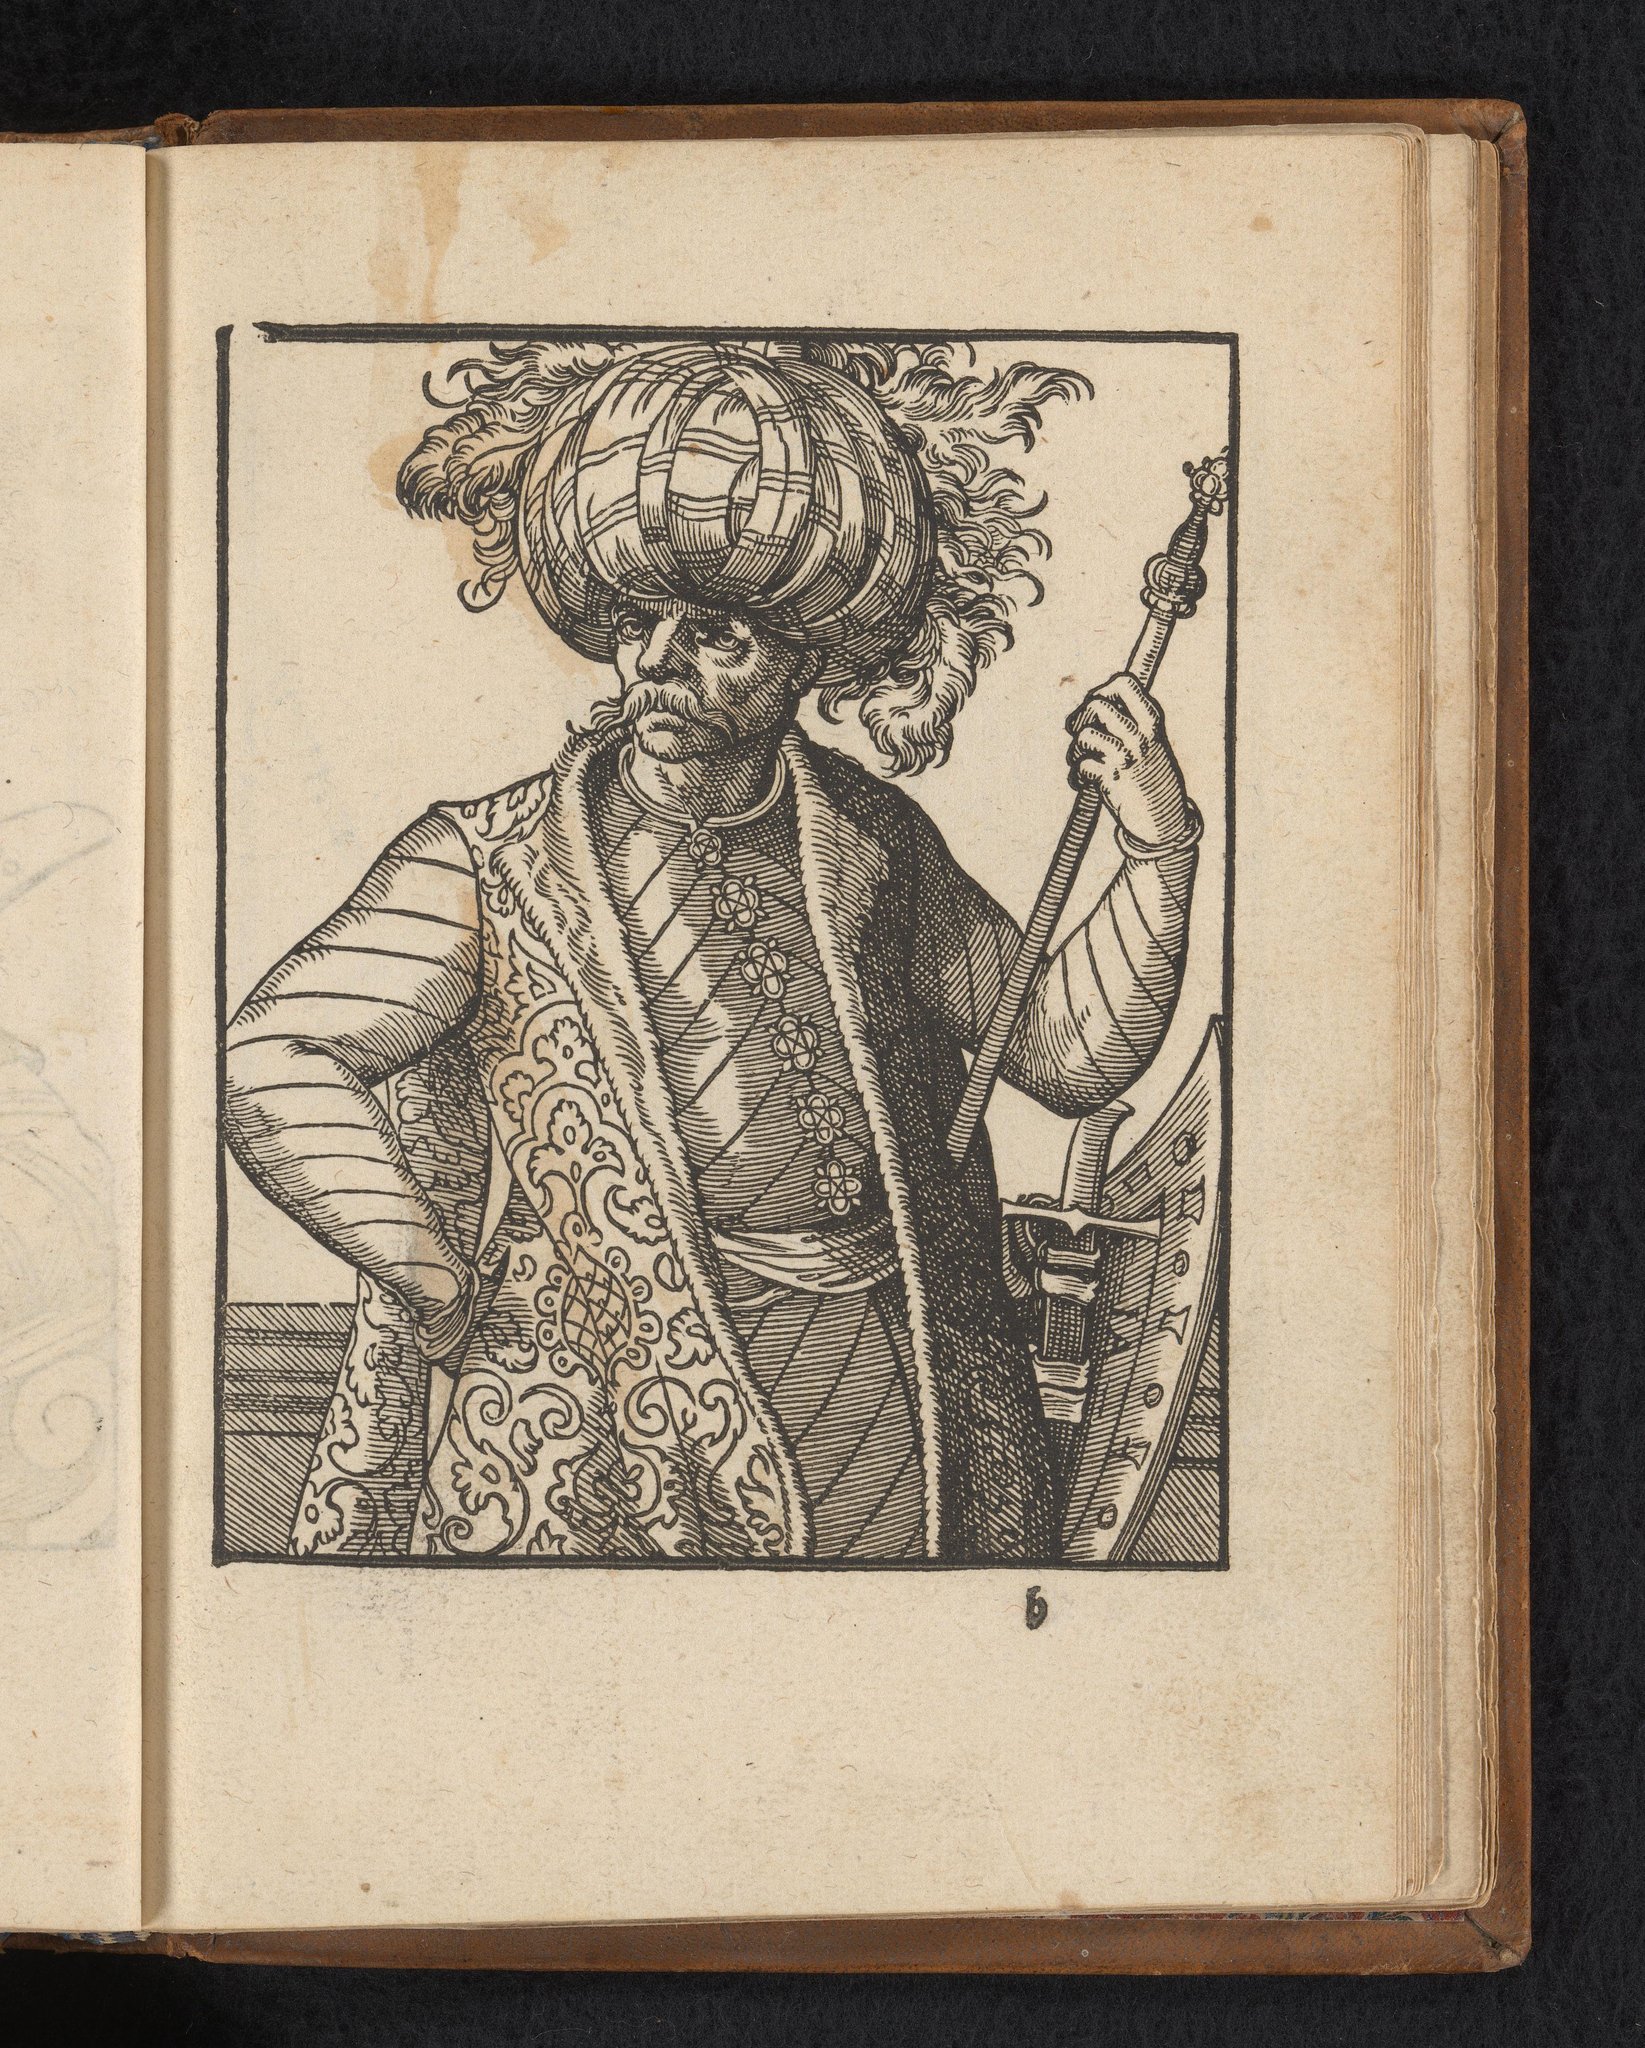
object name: print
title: Ottomaanse veldheer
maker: Anonymous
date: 1578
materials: paper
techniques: woodcut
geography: nuremberg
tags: asiatic races and peoples: turks, head-gear: turban, the soldier; the soldier's life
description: Een Ottomaanse veldheer, van voren gezien, scepter in de hand, op het hoofd een tulband met pluimen. Onderdeel van het modelboek Enchiridion artis pingendi, fingendi & sculpendi met 108 figuren bedoeld voor beginnende schilders, beeldhouwers en prentmakers.